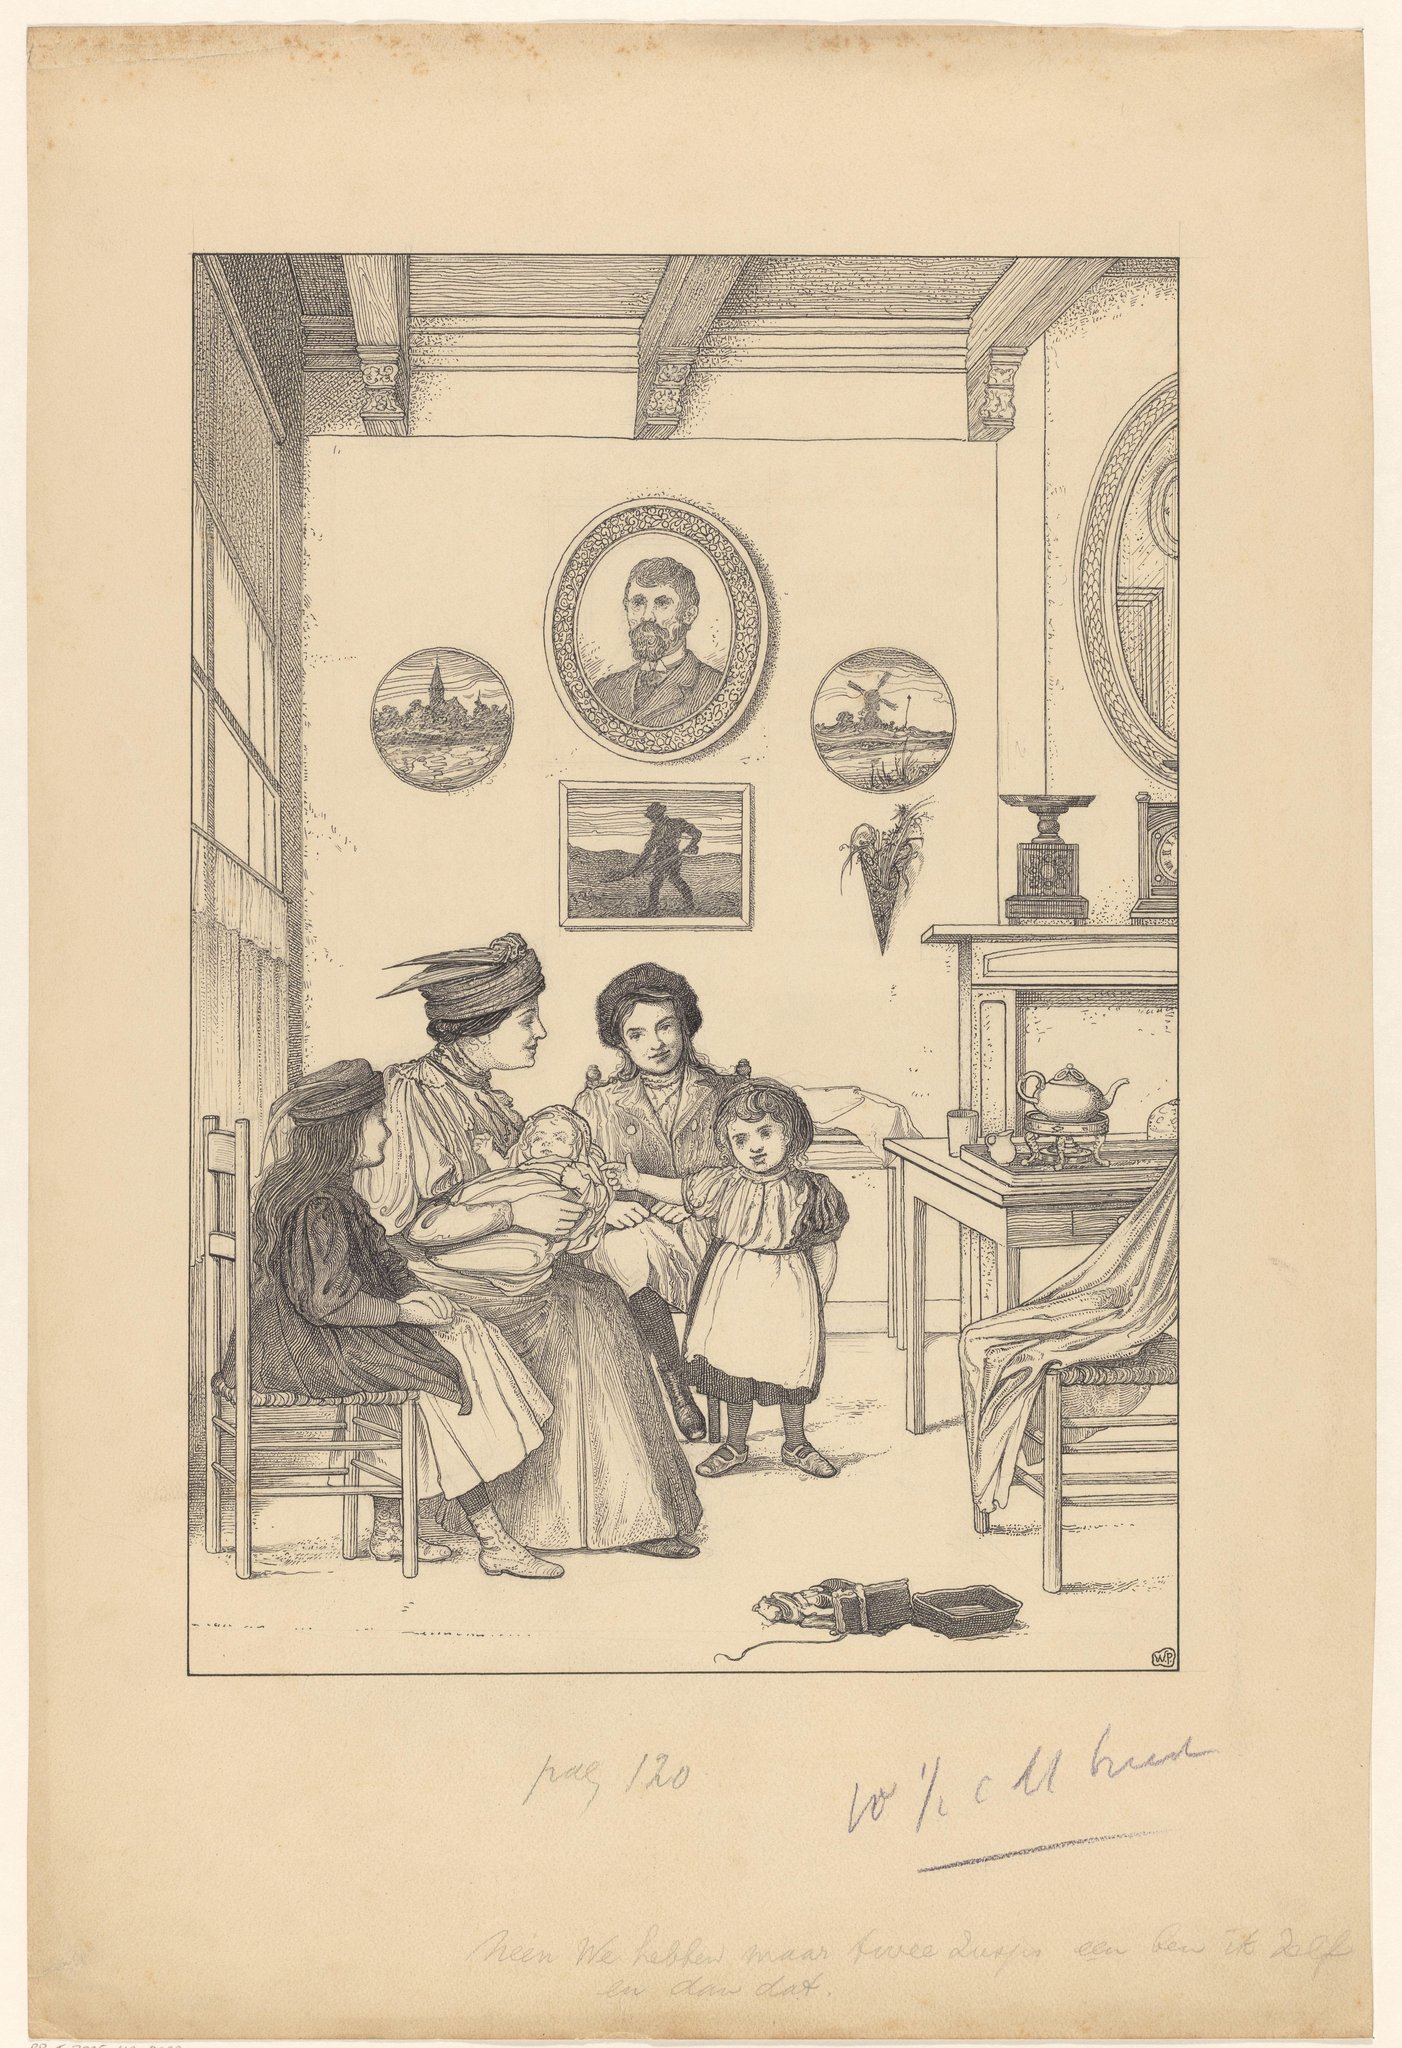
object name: boekillustratie ontwerp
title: Gezelschap met baby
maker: willem pothast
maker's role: draughtsman, print maker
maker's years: 1877-1916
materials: ink, paper, pencil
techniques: pen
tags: interior of the house, tea-pot; samovar, infant, baby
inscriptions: collector's mark: Lugt 2228, signature: ‘W.P.’, :, annotation: ‘pag 120/ Neen we hebben maar twee zusjes een ben ik zelf/ en dan dat.’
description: In een interieur zit een vrouw met een baby op schoot bij een venster. Om haar heen zitten een vrouw en meisje en staat een peuter, die haar hand naar de baby uitsteekt. Aan de wand hangen schilderijen, waaronder een portret en landschappen. Op tafel staat een theeservies.